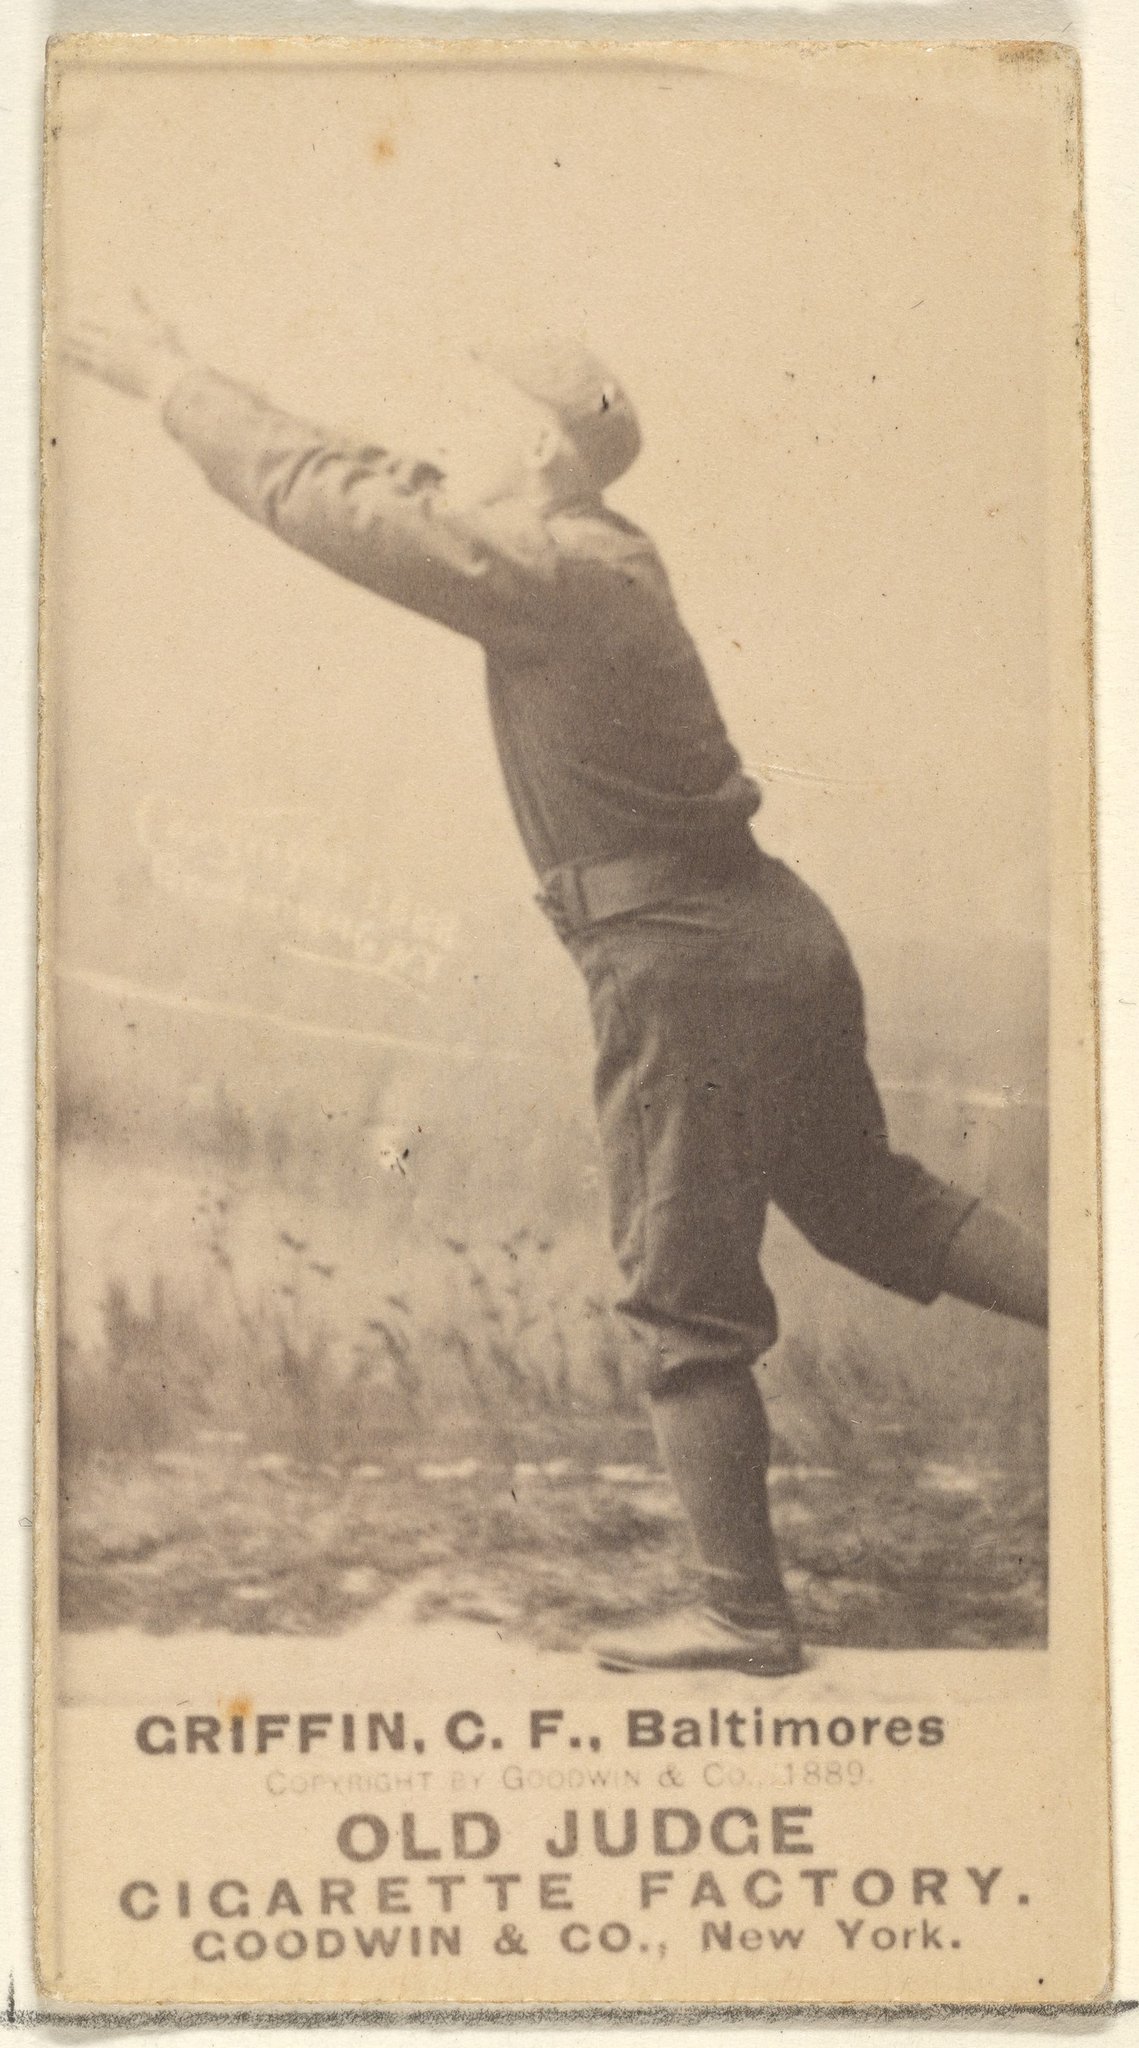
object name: baseball card, photograph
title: Griffin, Center Field, Baltimore Orioles, from the Old Judge series (N172) for Old Judge Cigarettes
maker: goodwin & company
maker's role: publisher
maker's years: 1850-1950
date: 1889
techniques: albumen silver print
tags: men,portraits,baseball,athletes